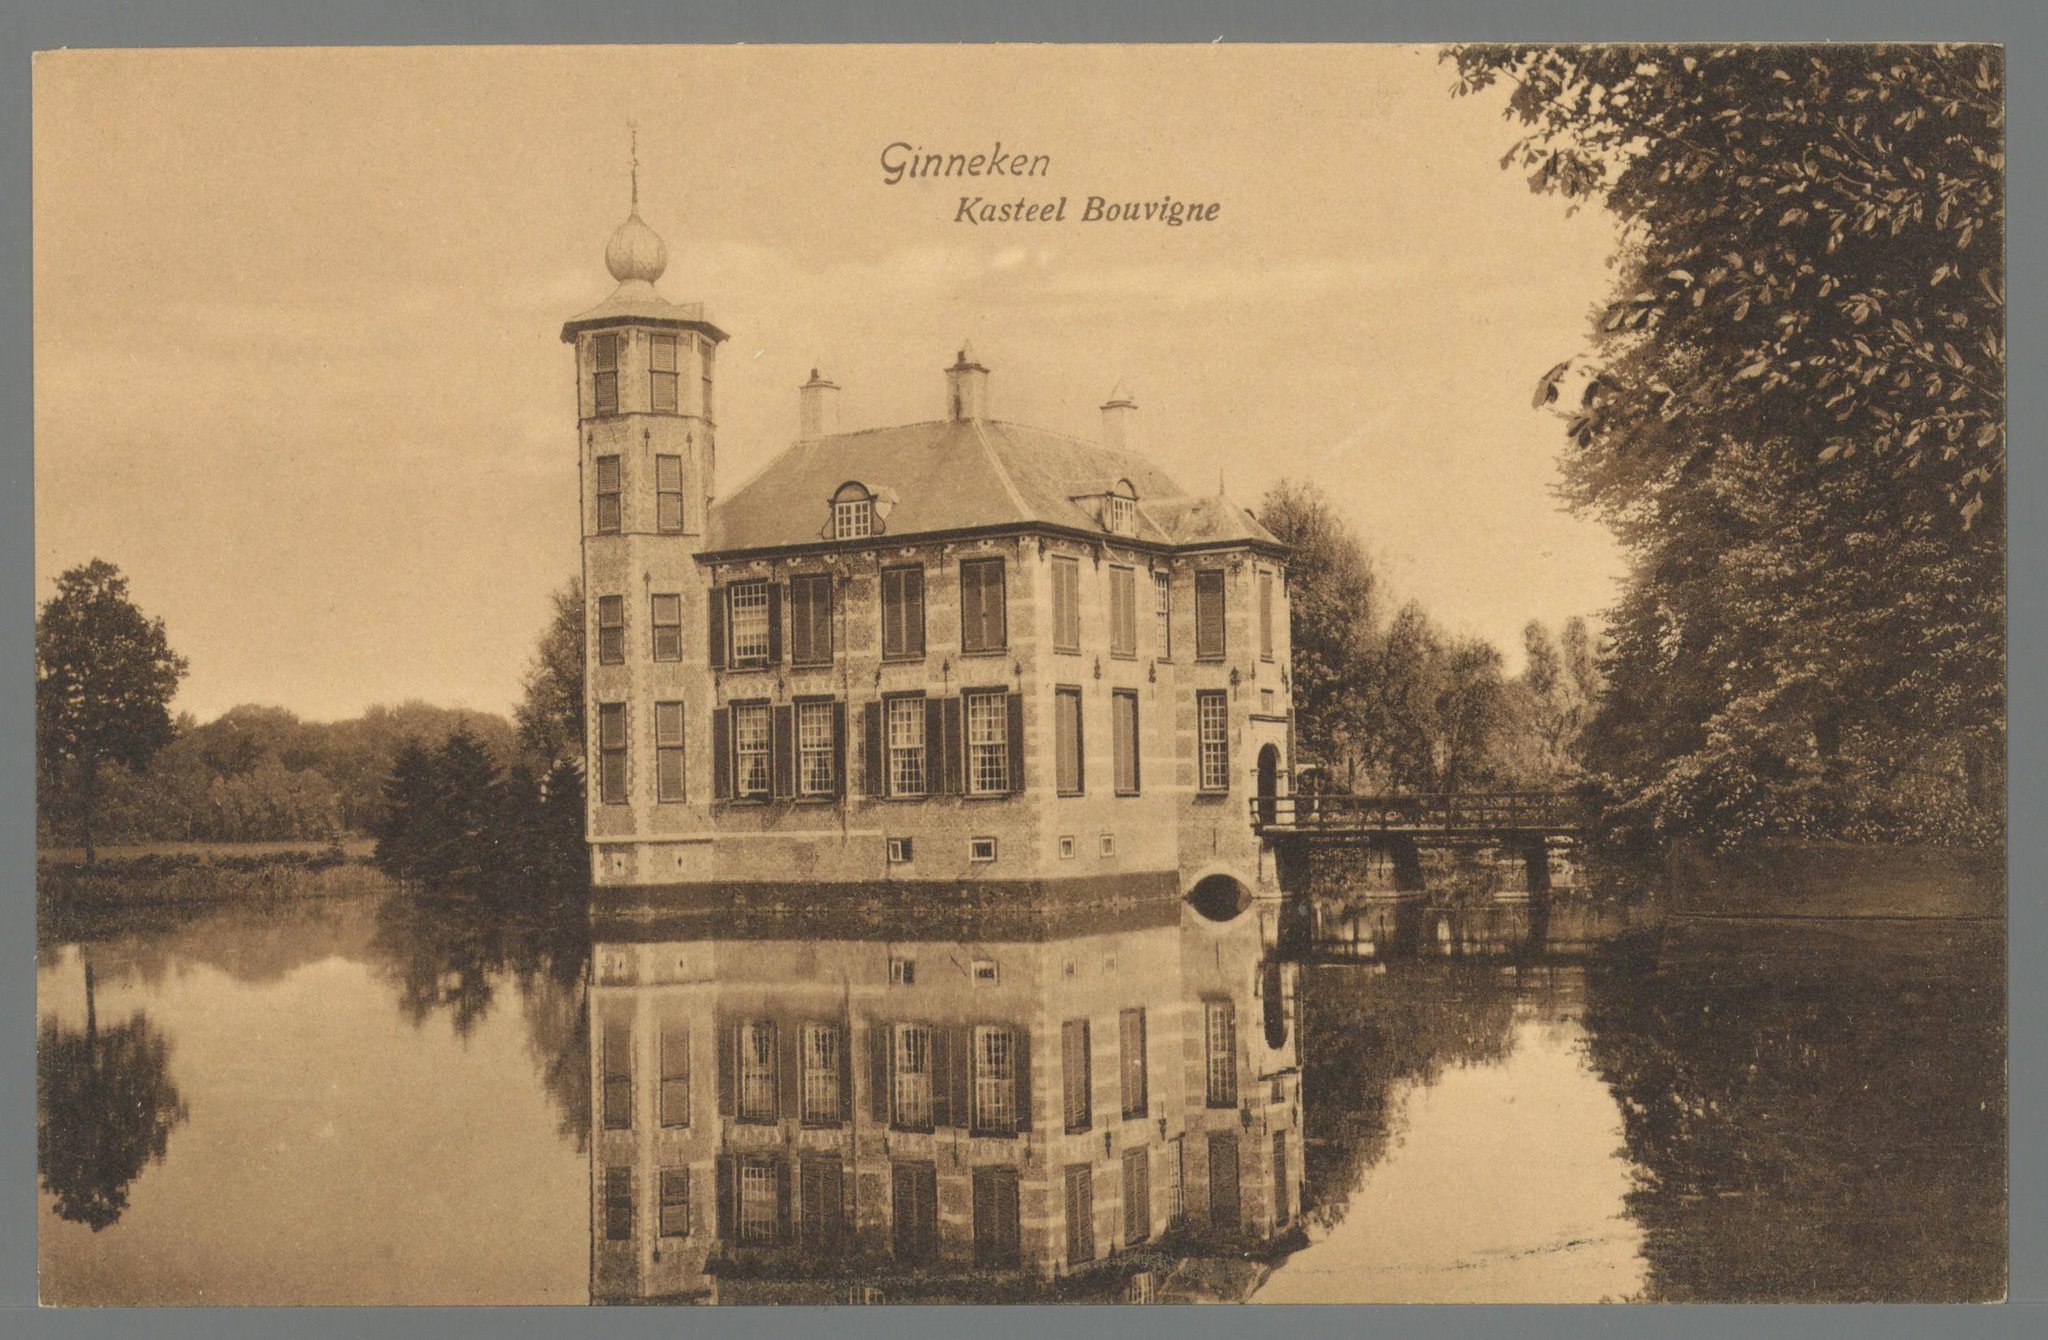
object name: ansichtkaart, prentbriefkaart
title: Ginneken. Kasteel Bouvigne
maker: Anonymous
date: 1910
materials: cardboard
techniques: photograph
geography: ginneken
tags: castle, canal, canals, waters (in village)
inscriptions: date